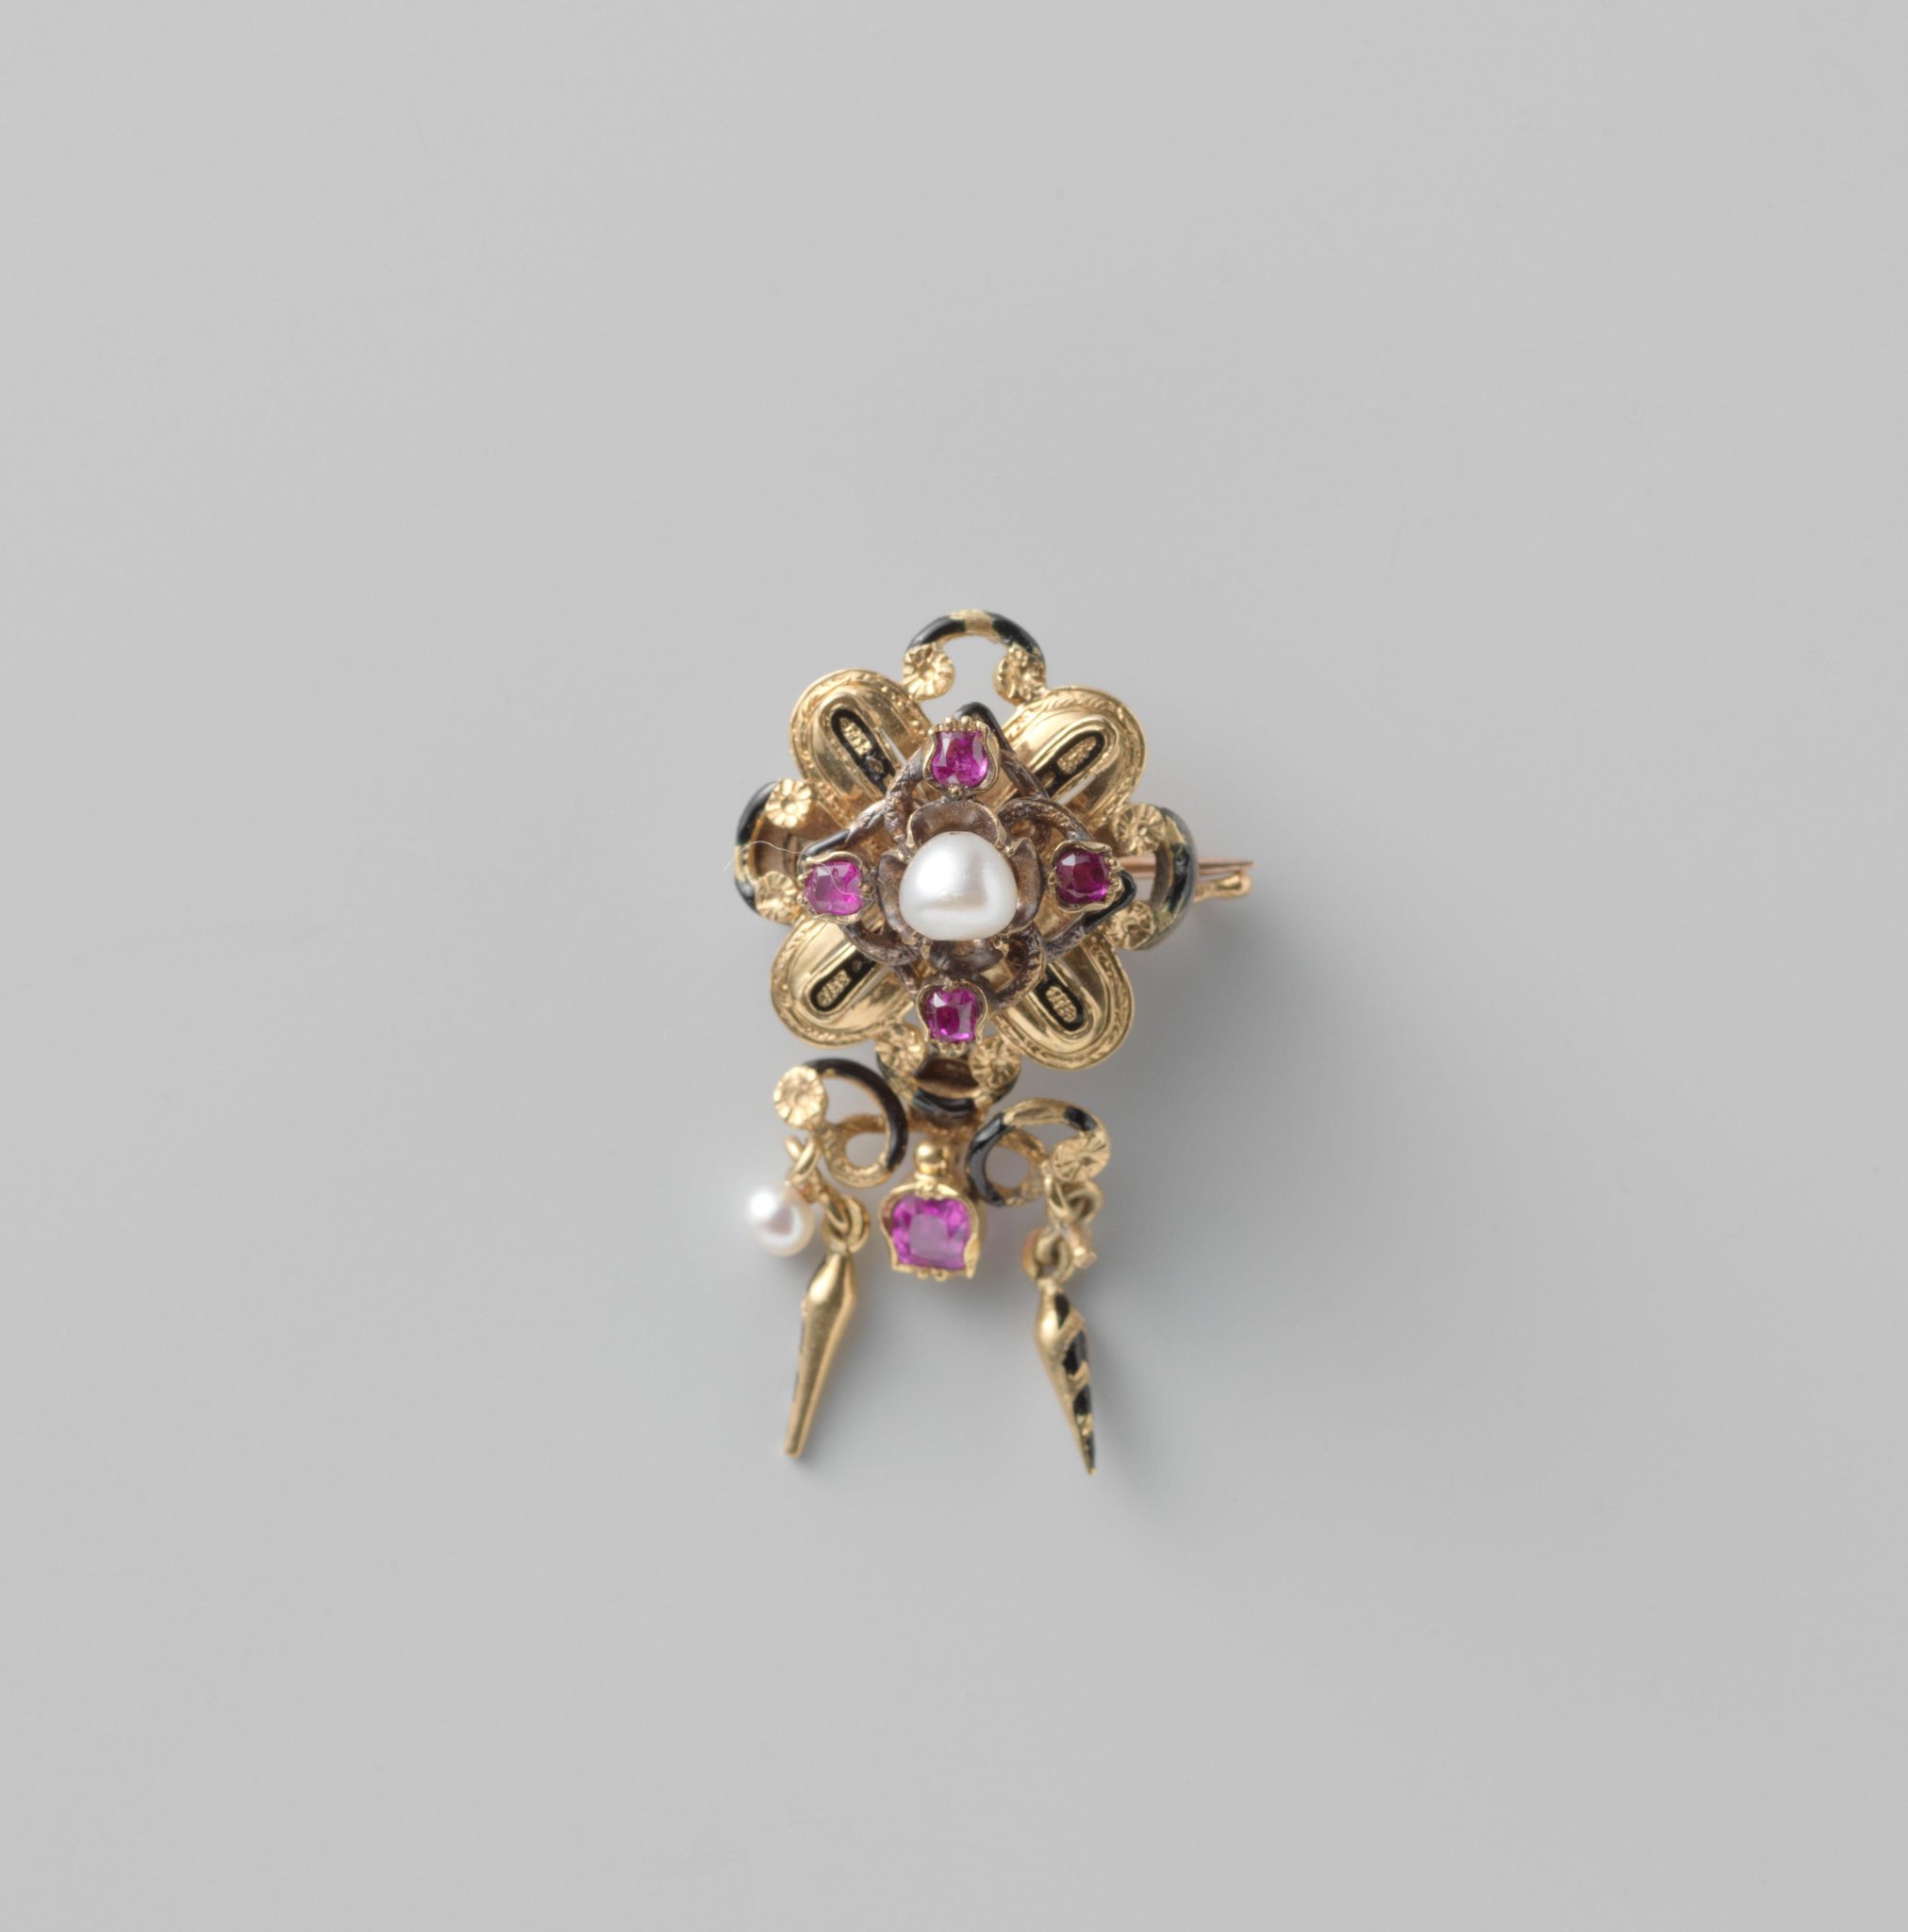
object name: brooch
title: Broche van goud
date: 1800-1900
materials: gold, pearl, gemstone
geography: netherlands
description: Broche van goud met vier robijnen en een parel. Aan de broche een aanhanger met een robijn en twee parels, waarvan er 1 ontbreekt.